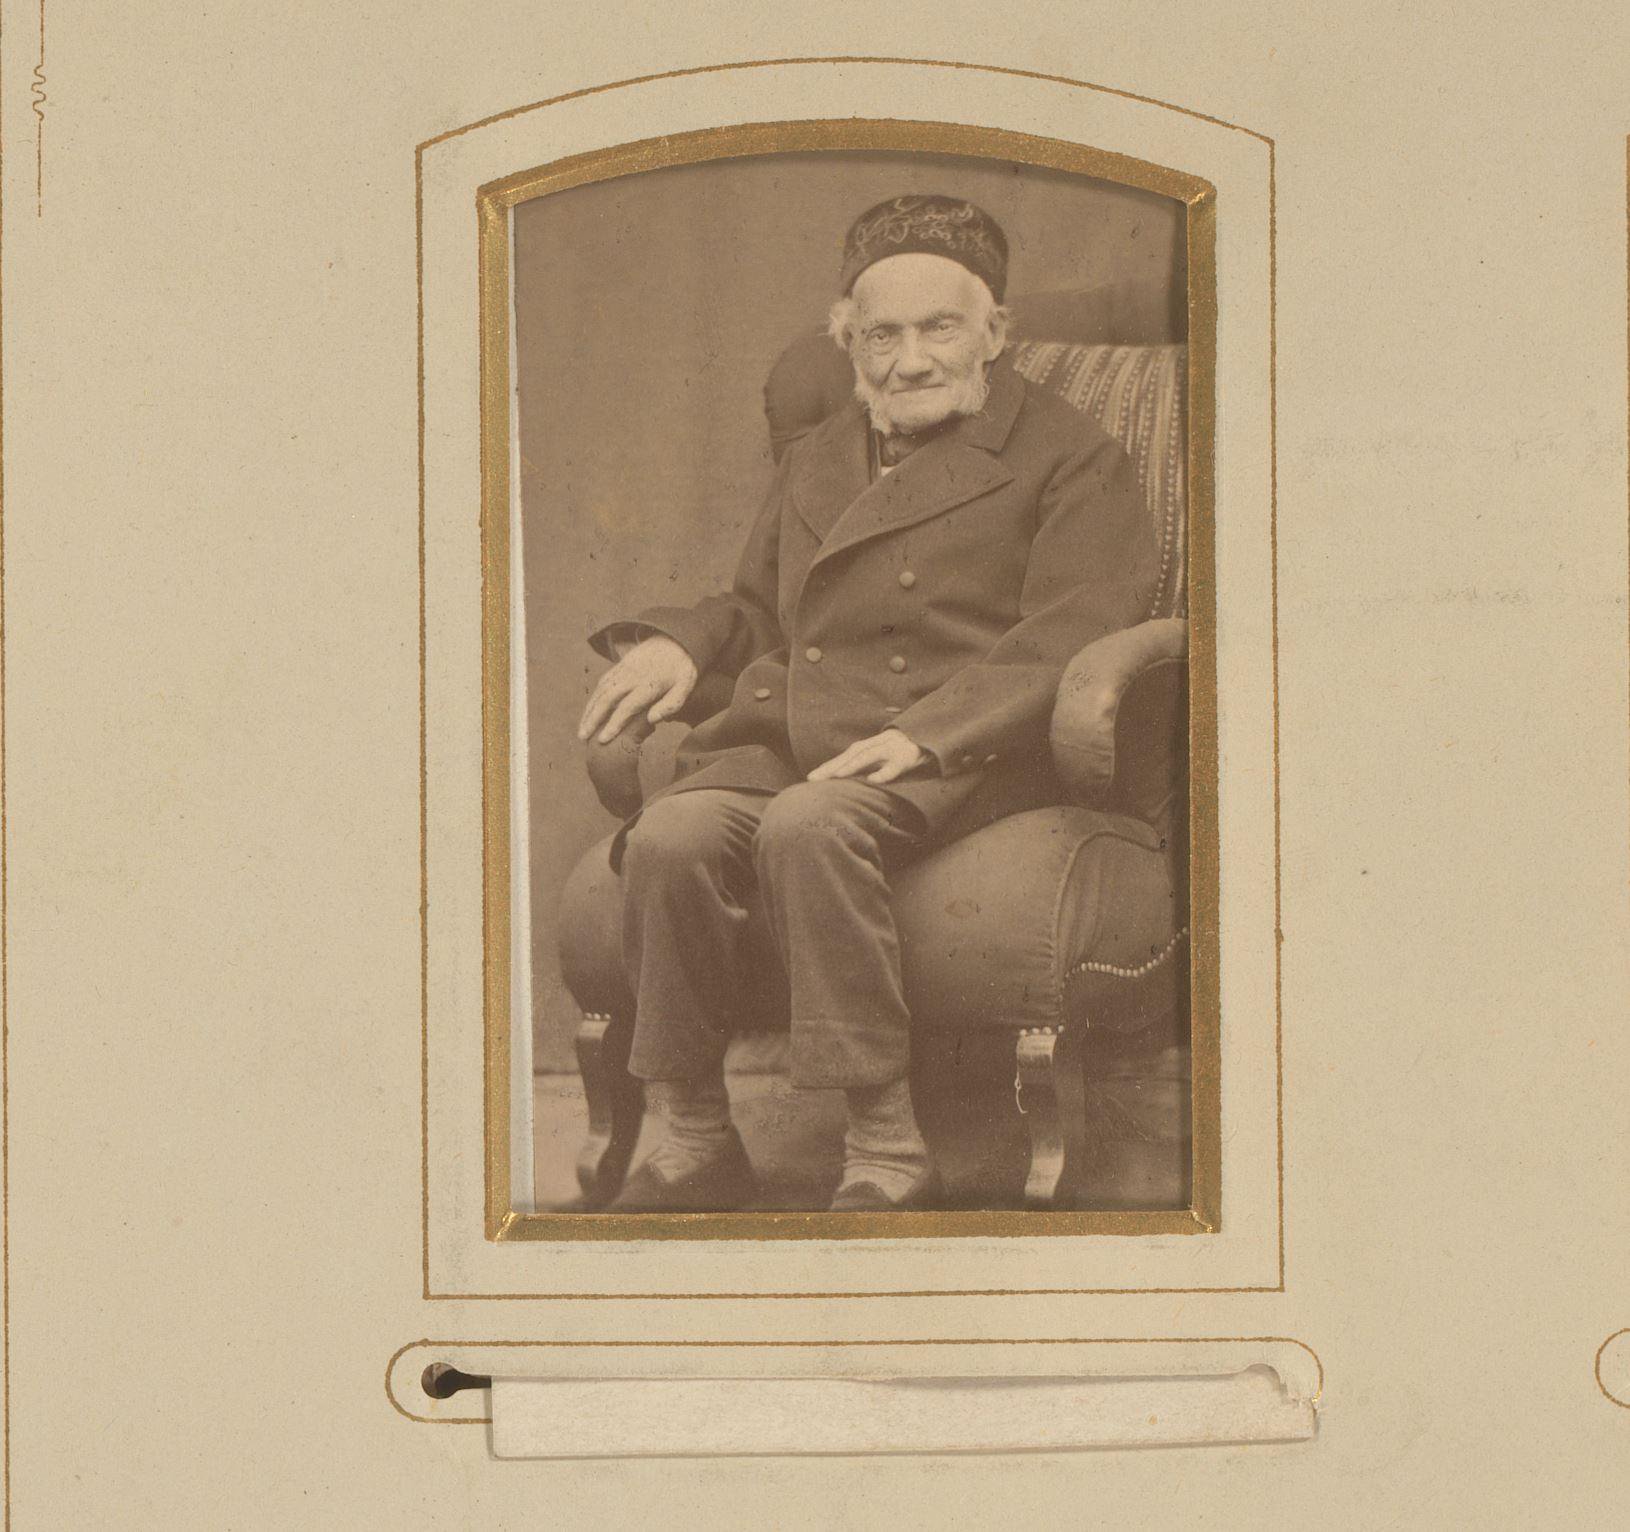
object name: photograph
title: Portret van een oude man in een stoel, aangeduid als C. H. Tölle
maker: Anonymous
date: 1850-1900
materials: cardboard, photographic support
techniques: albumen print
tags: historical persons, old man, chair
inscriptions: name: ‘C. H. Tölle 90[Y].’